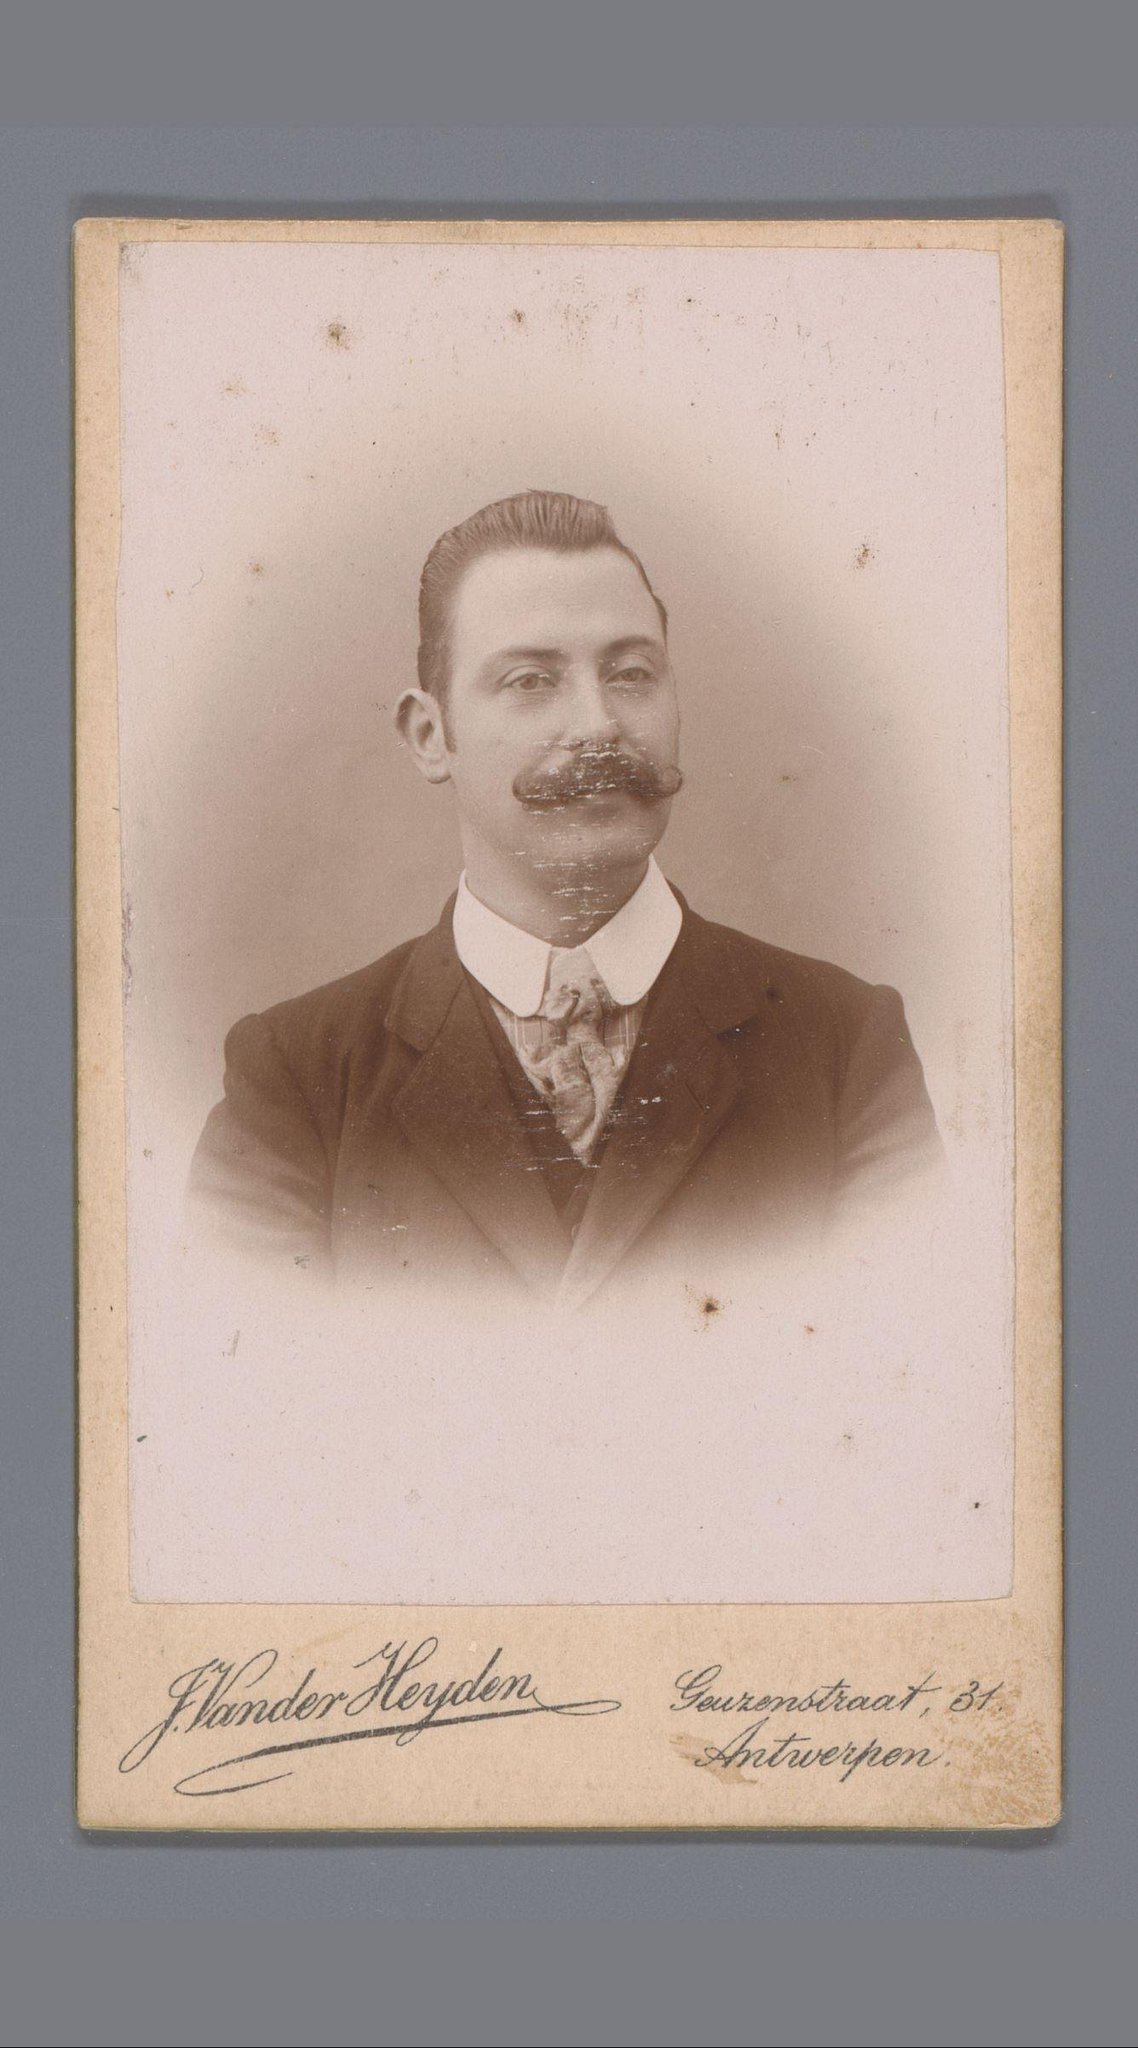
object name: photograph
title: Portret van een onbekende man met snor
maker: j.h. v.d. heijden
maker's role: fotograaf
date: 1880-1900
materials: cardboard, photographic support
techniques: collodion silver print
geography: antwerp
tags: moustache, adult man, historical persons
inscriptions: inscription: ‘Photographie/ Artistique/ J. Van der Heyden/ Photographe Dessinateur/ SPÉCIALITÉ/ de Portraits/ Peints & Dessinés/ rue des Gueux, 31/ ANVERS/ Les clichés sont conservés/ J. Auenaerde Gand’